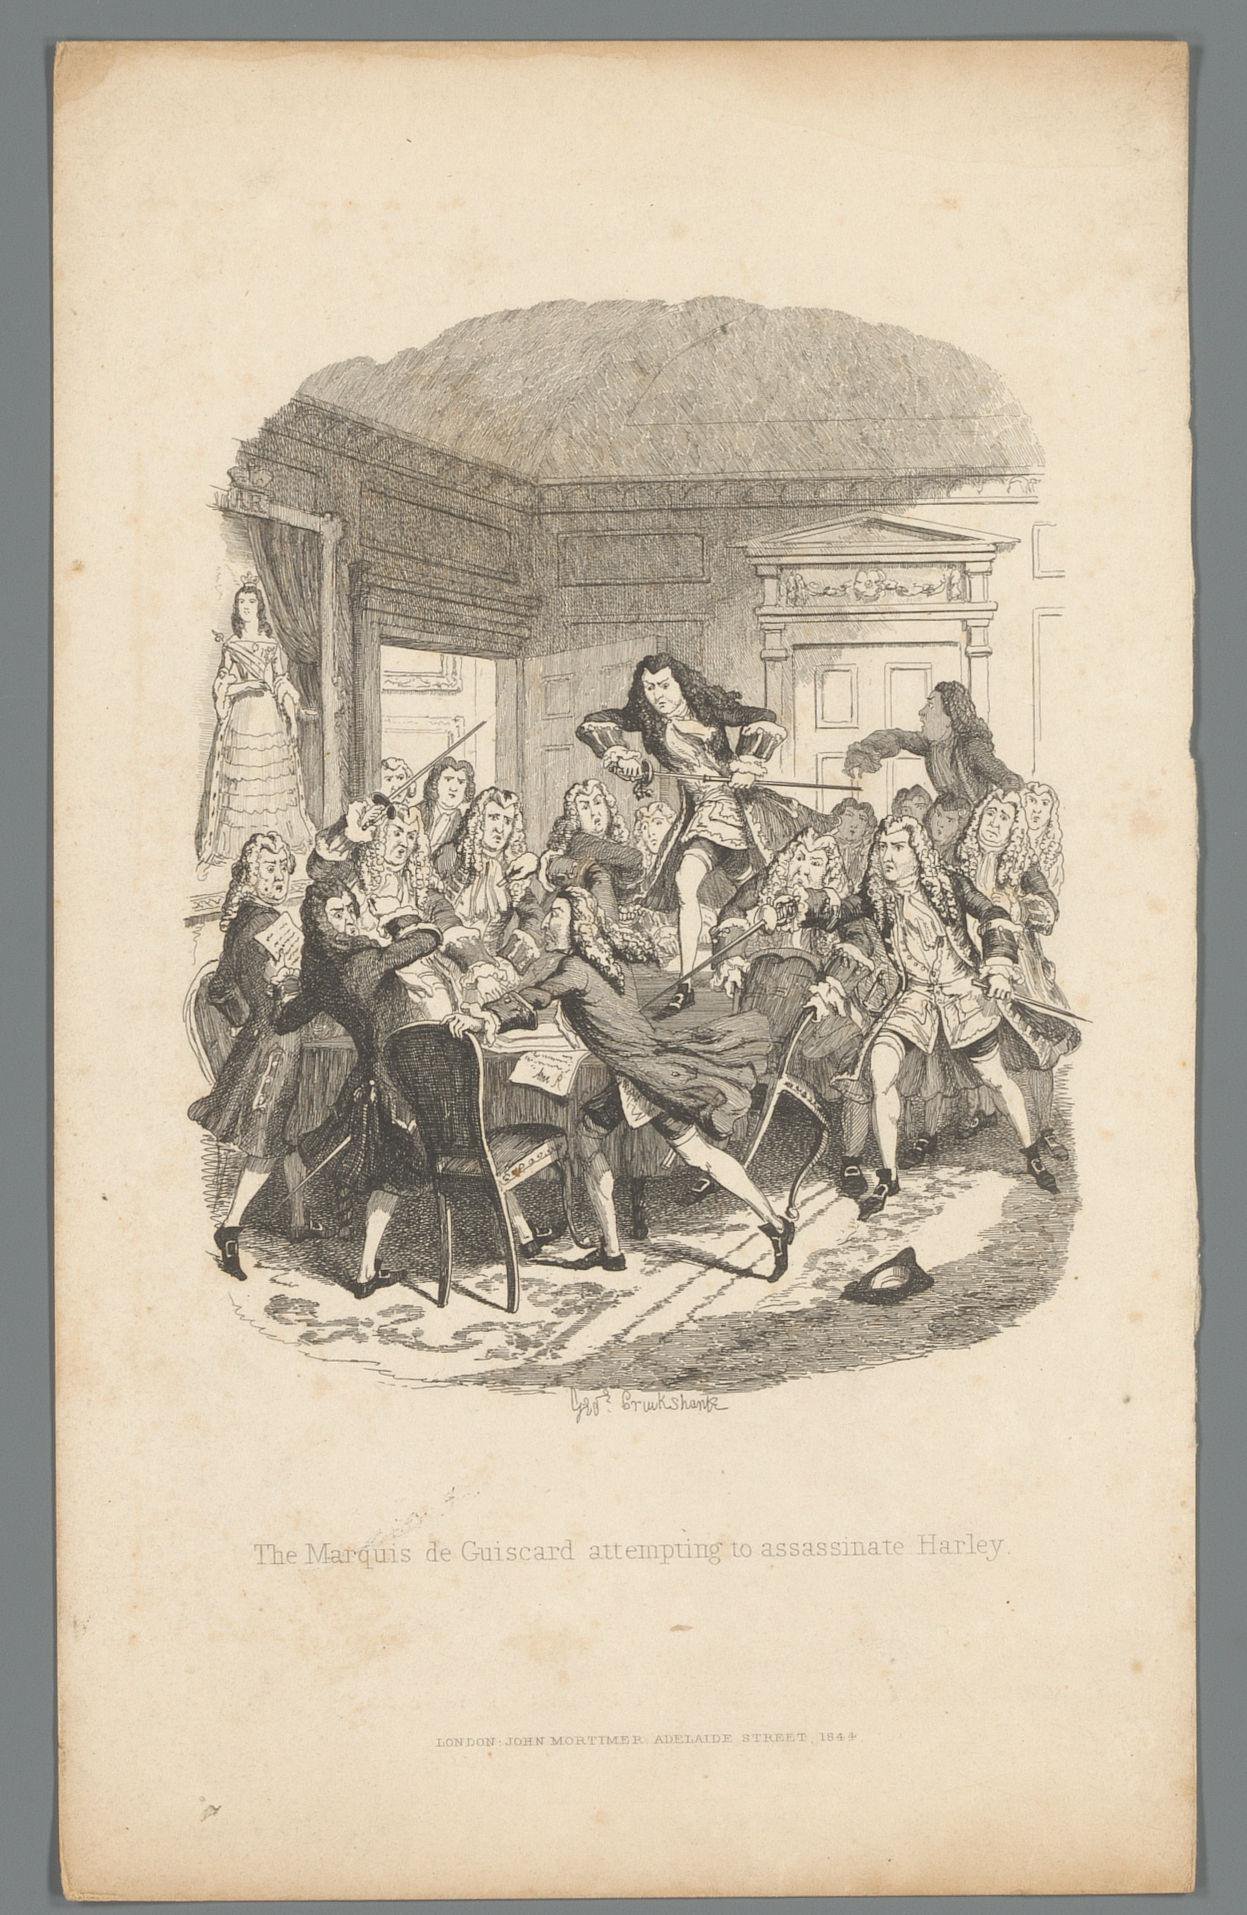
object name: book illustration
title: The Marquis de Guiscard attempting to assassinate Harley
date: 1844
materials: paper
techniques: etching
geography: london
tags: attempt, political murder, political caricatures and satires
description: Moordaanslag op Harley door de markies de Guiscard. Illustratie voor een uitgave van "St James's, or the Court of Queen Anne" van Ainsworth, 1844.